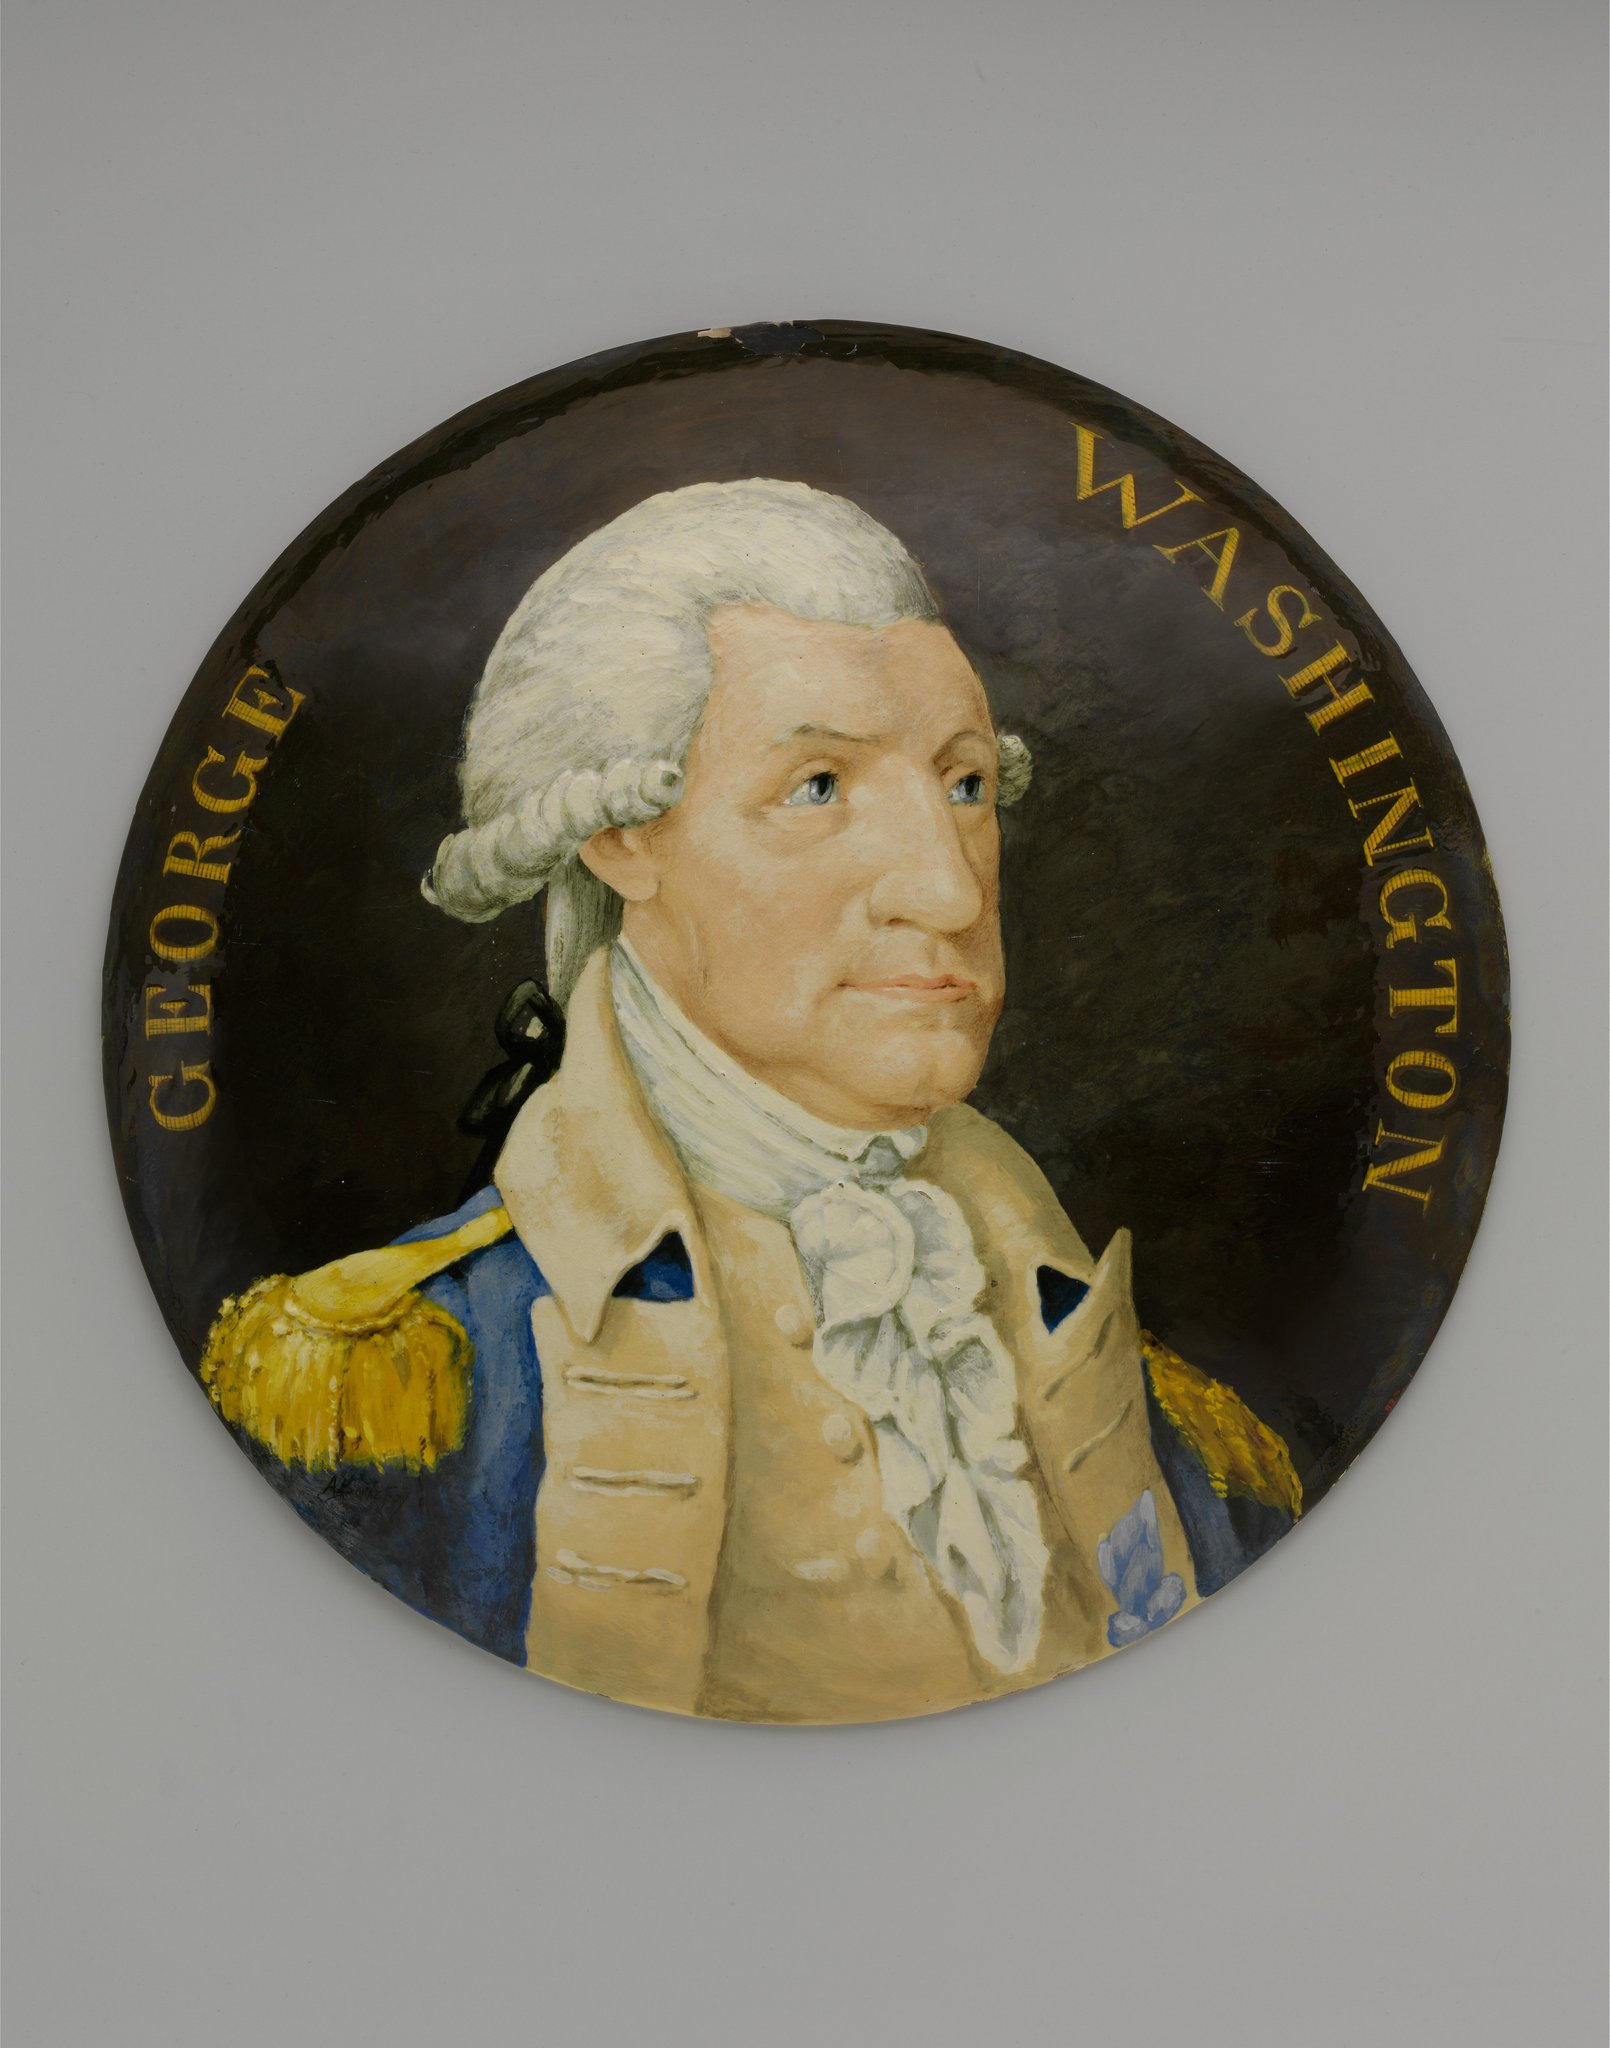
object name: plaque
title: George Washington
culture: french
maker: antoine bonnefoy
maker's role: maker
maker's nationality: french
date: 1776-1800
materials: faience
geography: france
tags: george washington,men,portraits